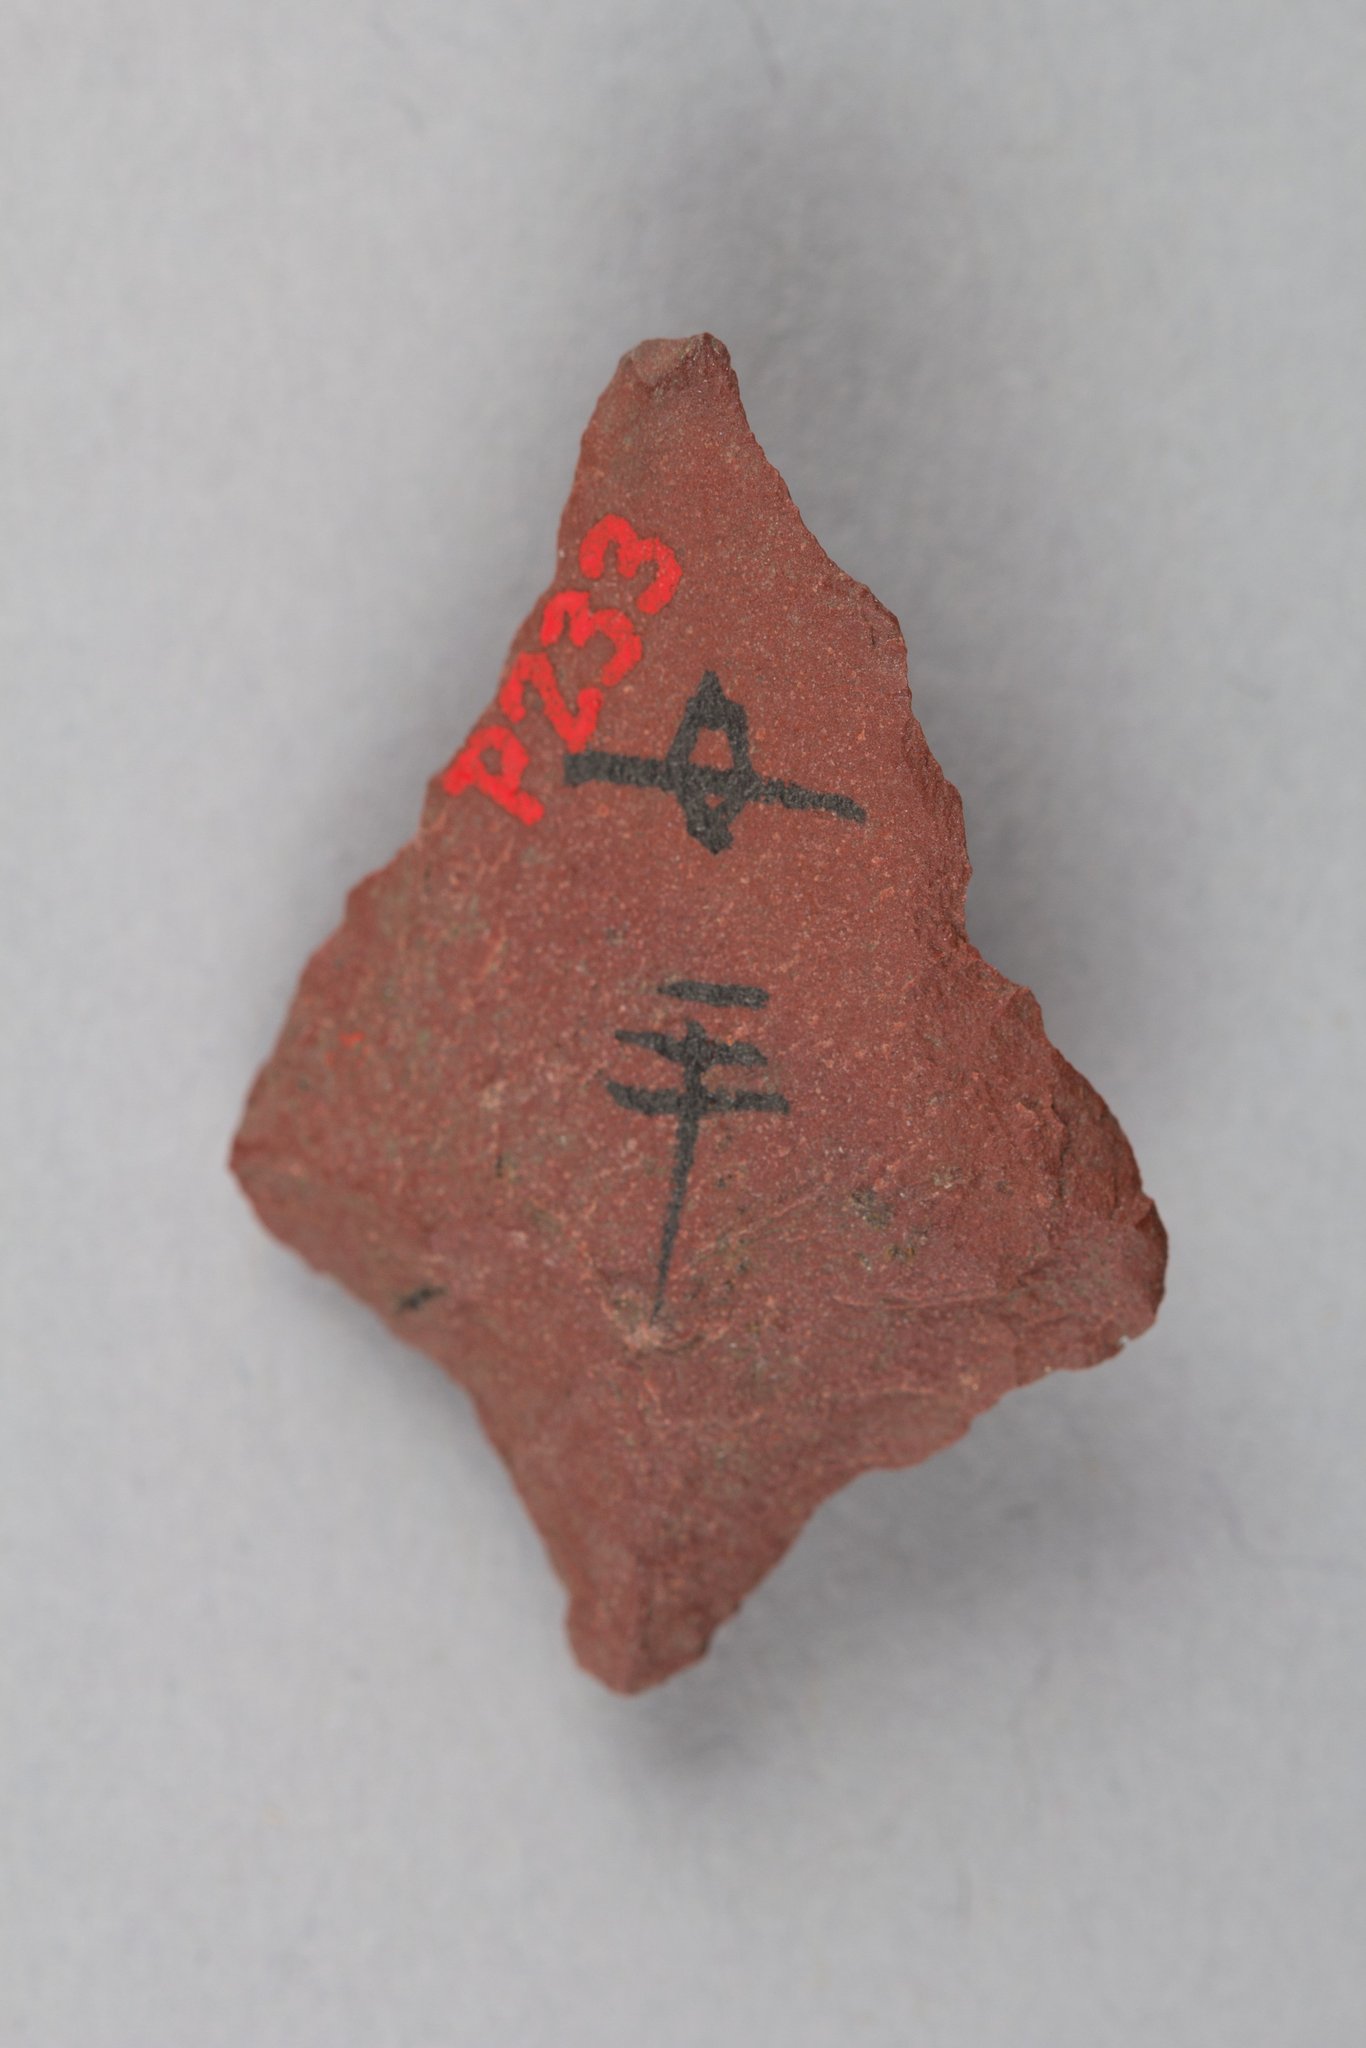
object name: arrowhead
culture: japanese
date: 1500-1000 BCE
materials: stone